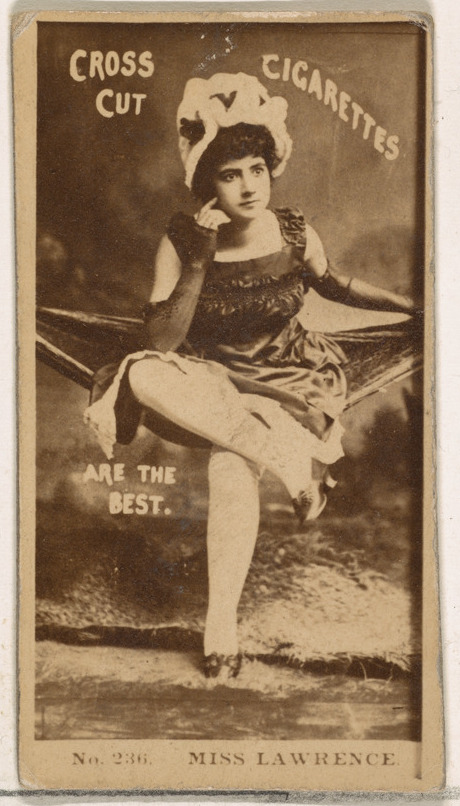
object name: print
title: Card Number 236, Miss Lawrence, from the Actors and Actresses series (N145-2) issued by Duke Sons & Co. to promote Cross Cut Cigarettes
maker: w. duke, sons & co.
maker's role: publisher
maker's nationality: american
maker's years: 1870-1920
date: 1880-1889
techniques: albumen silver print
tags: portraits,women,actresses